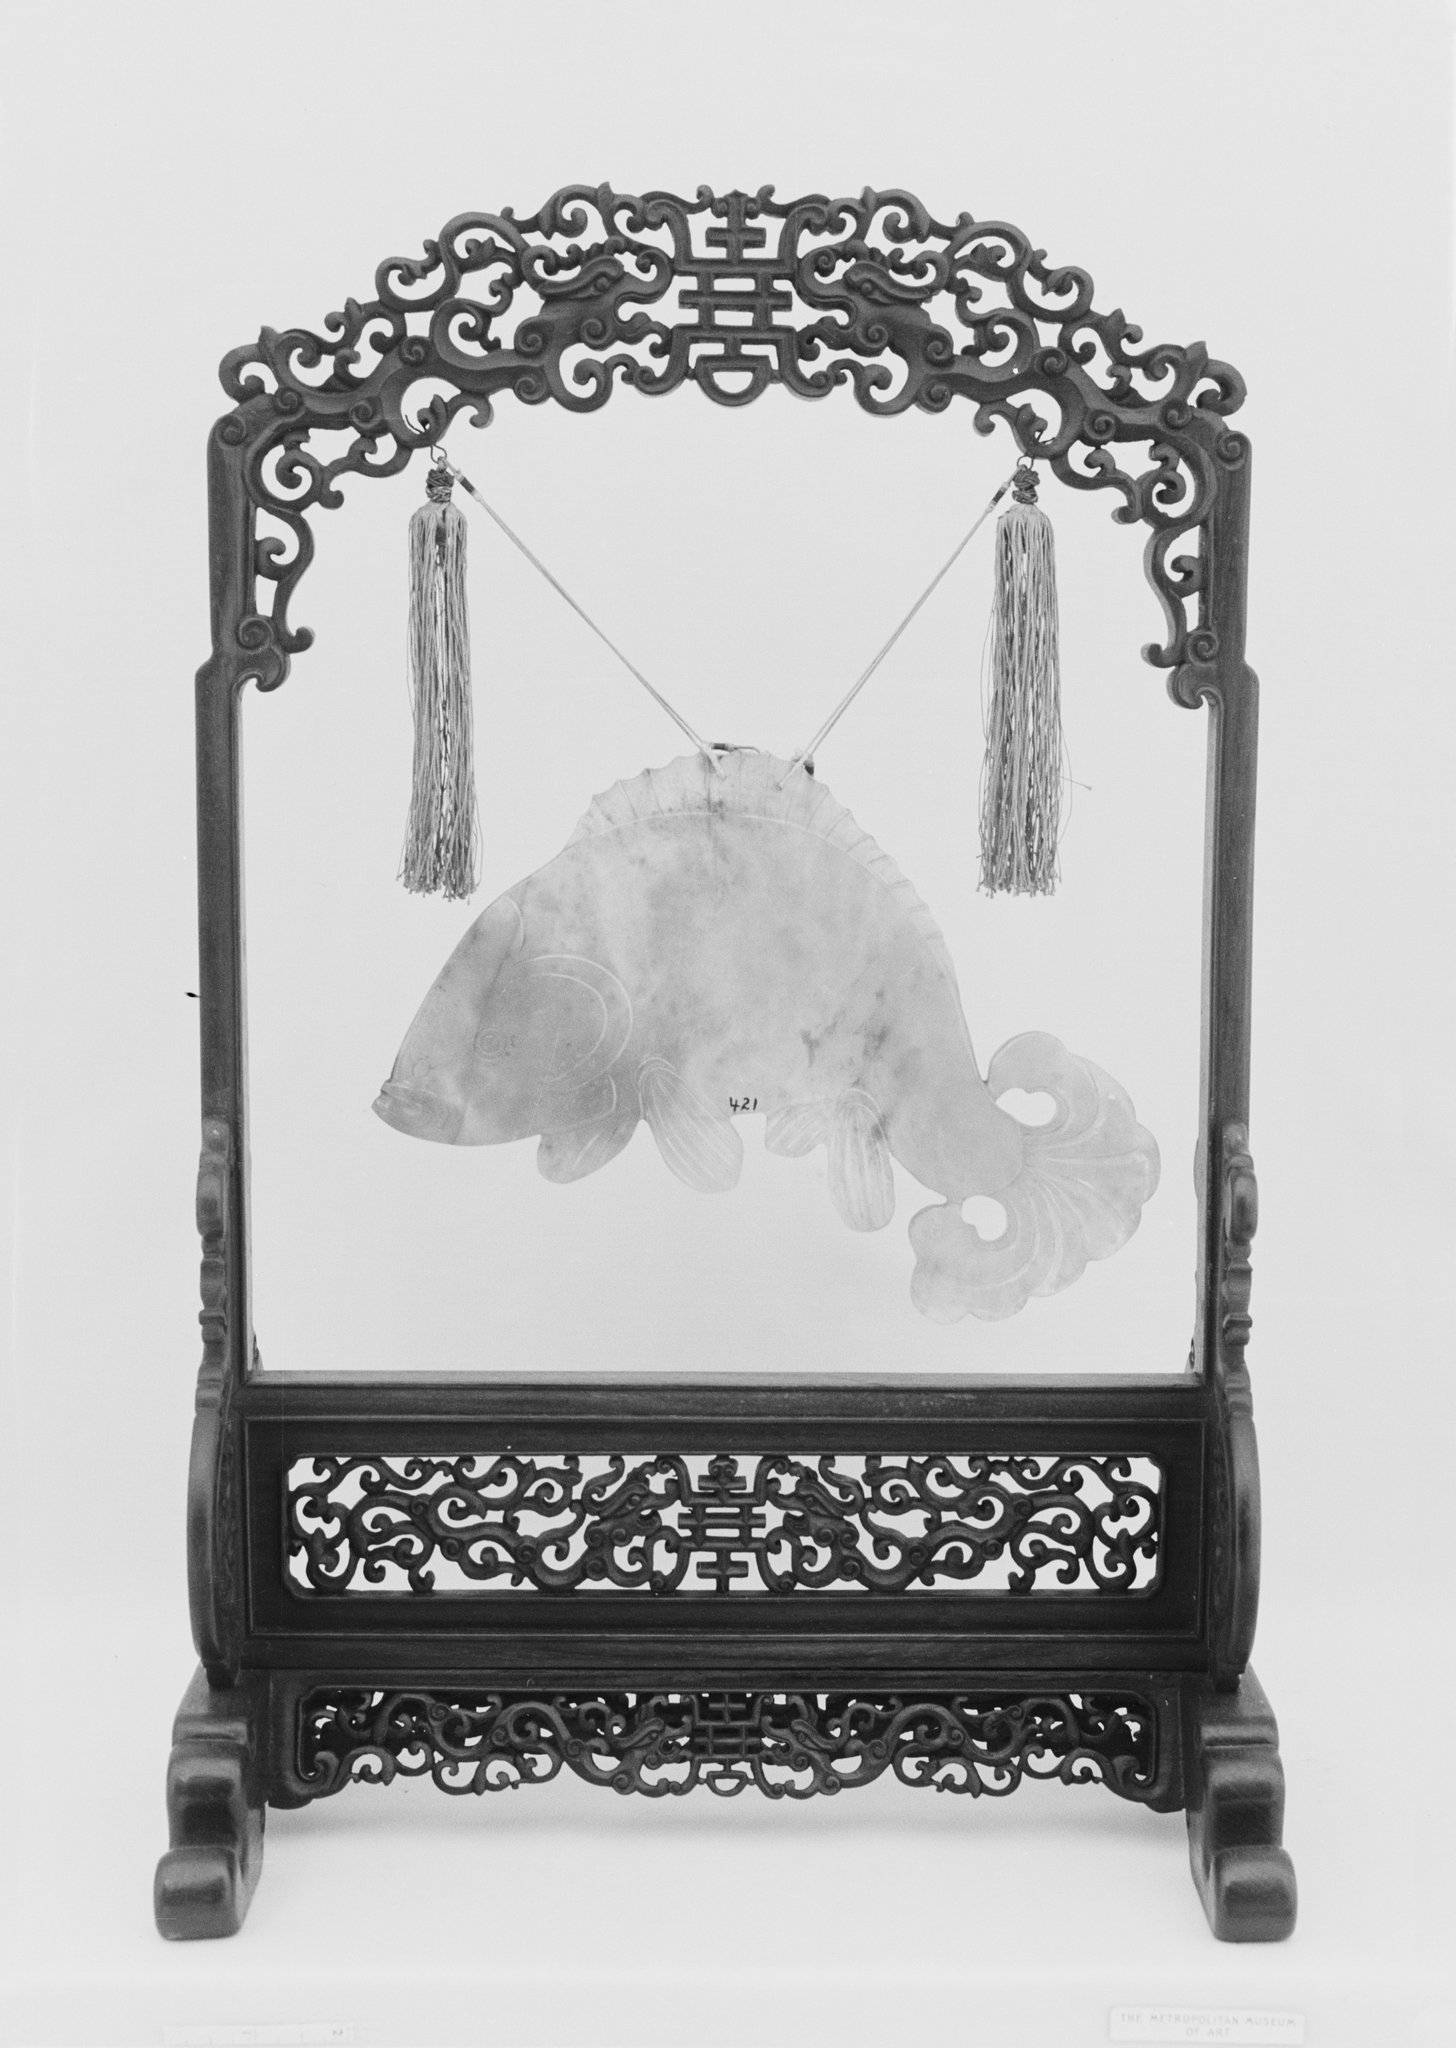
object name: gong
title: Fish Gong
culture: chinese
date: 1368-1644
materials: jade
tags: musical instruments,fish